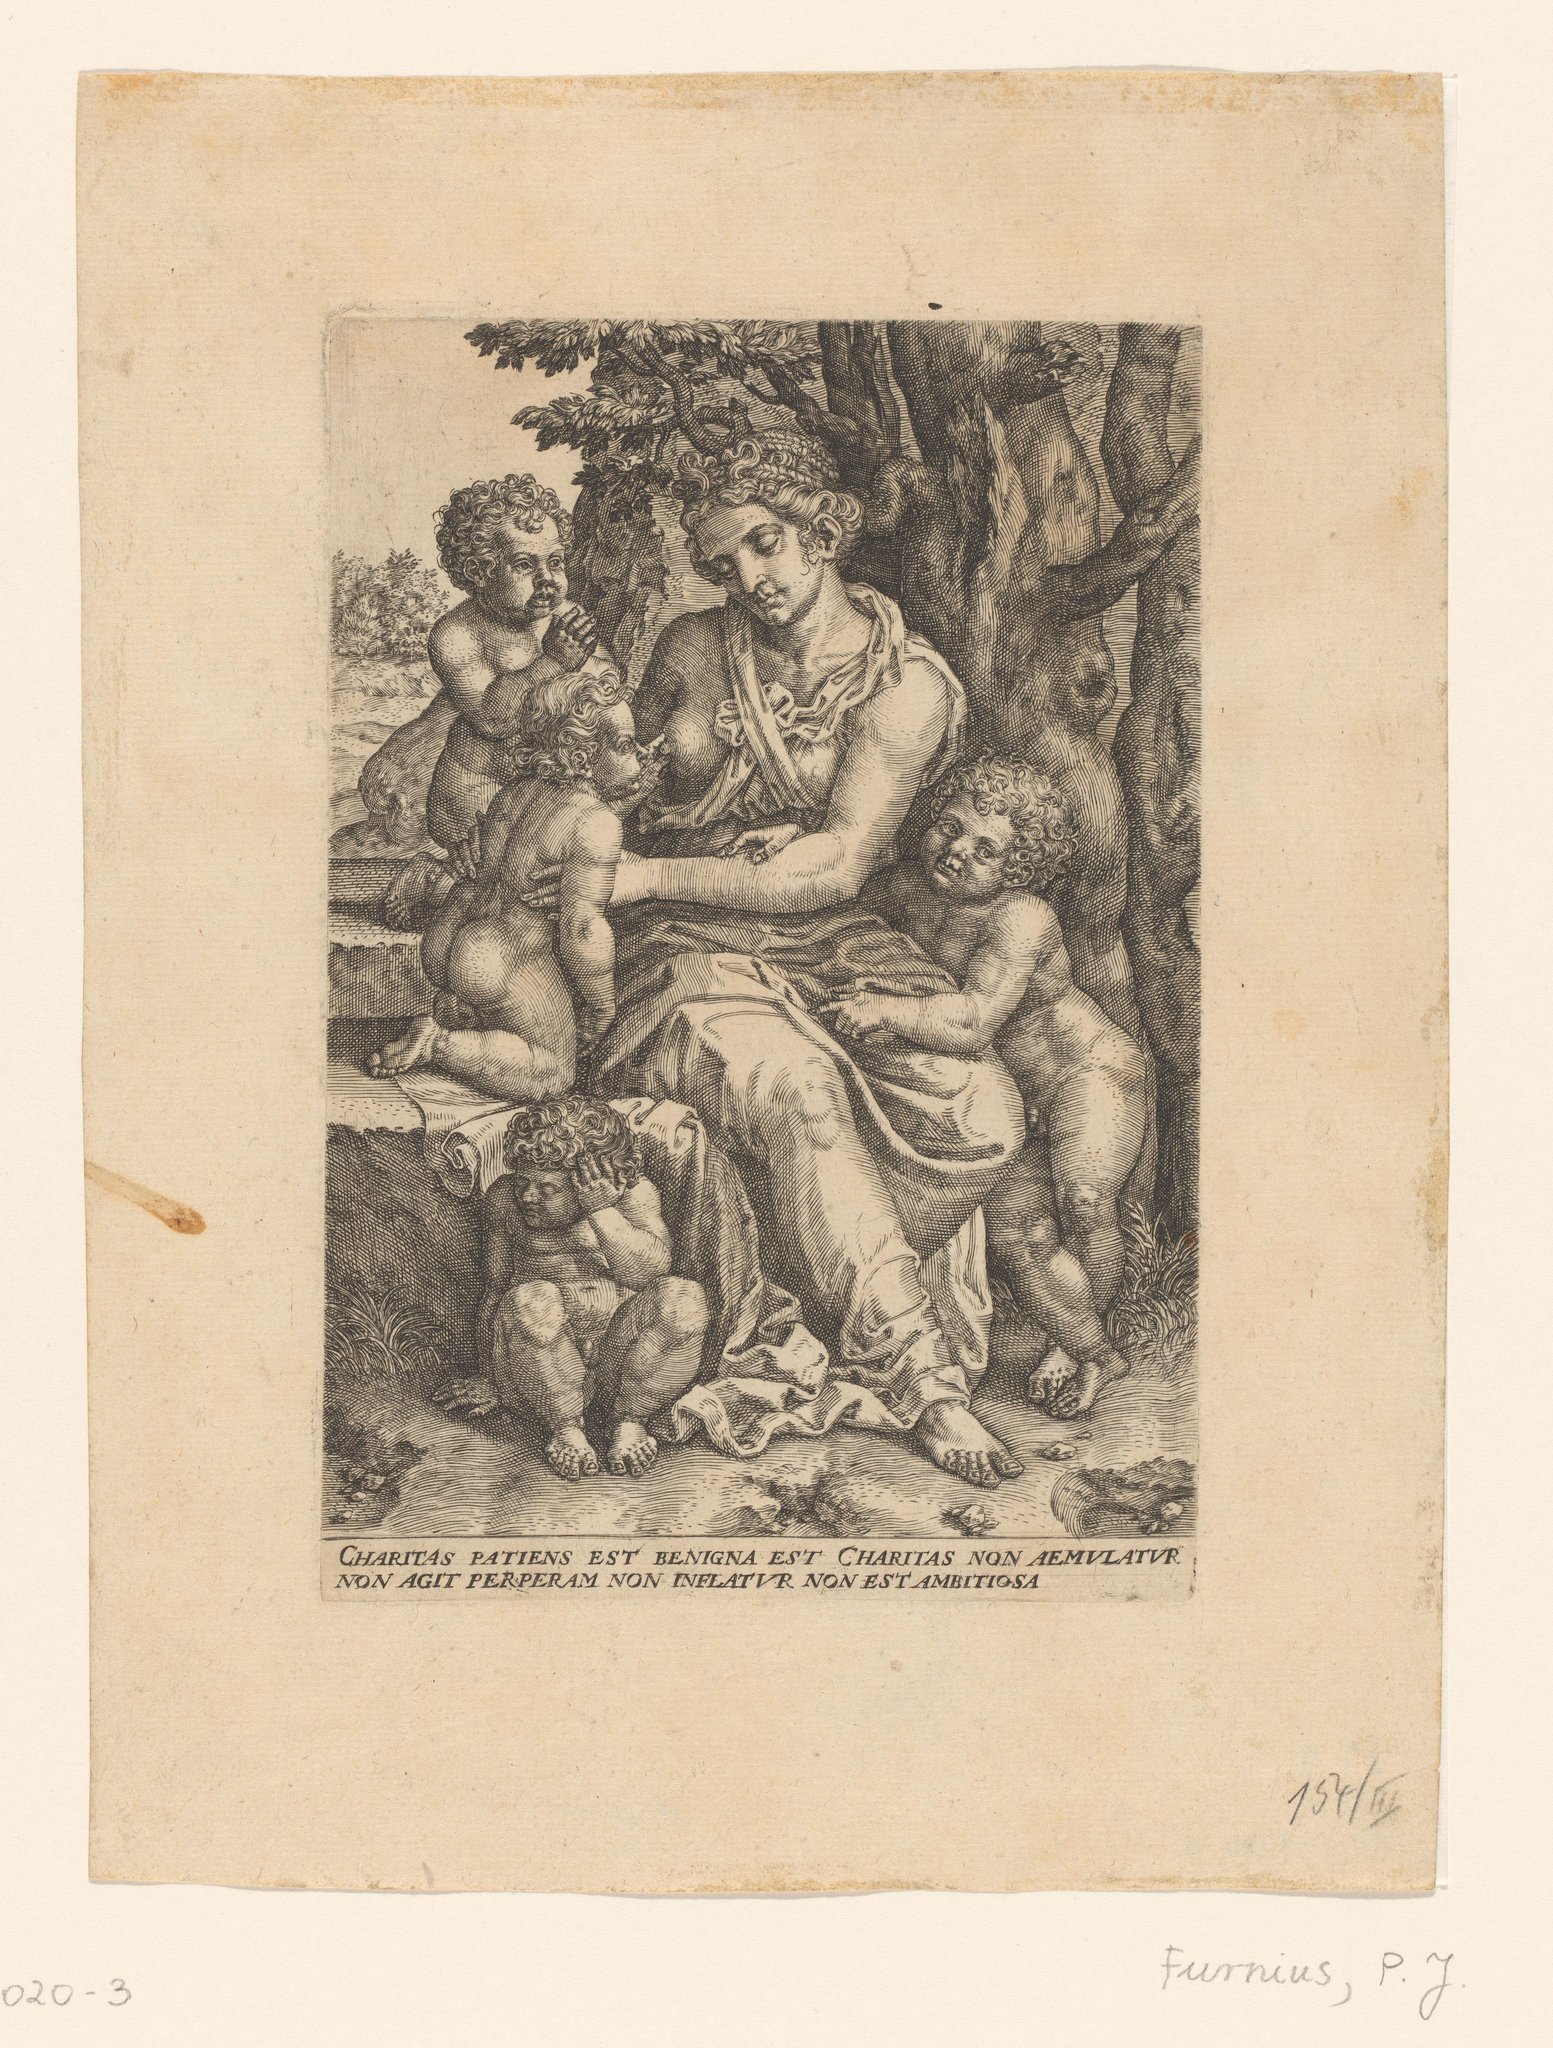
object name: print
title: Caritas (Liefde)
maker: pieter jalhea furnius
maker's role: print maker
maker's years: 1540-1626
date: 1575-1600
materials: paper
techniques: engraving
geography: southern netherlands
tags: charity, 'caritas'; 'carità' (ripa) ~ one of the three theological virtues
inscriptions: collector's mark: Lugt 2760, collector's mark: Lugt 2228